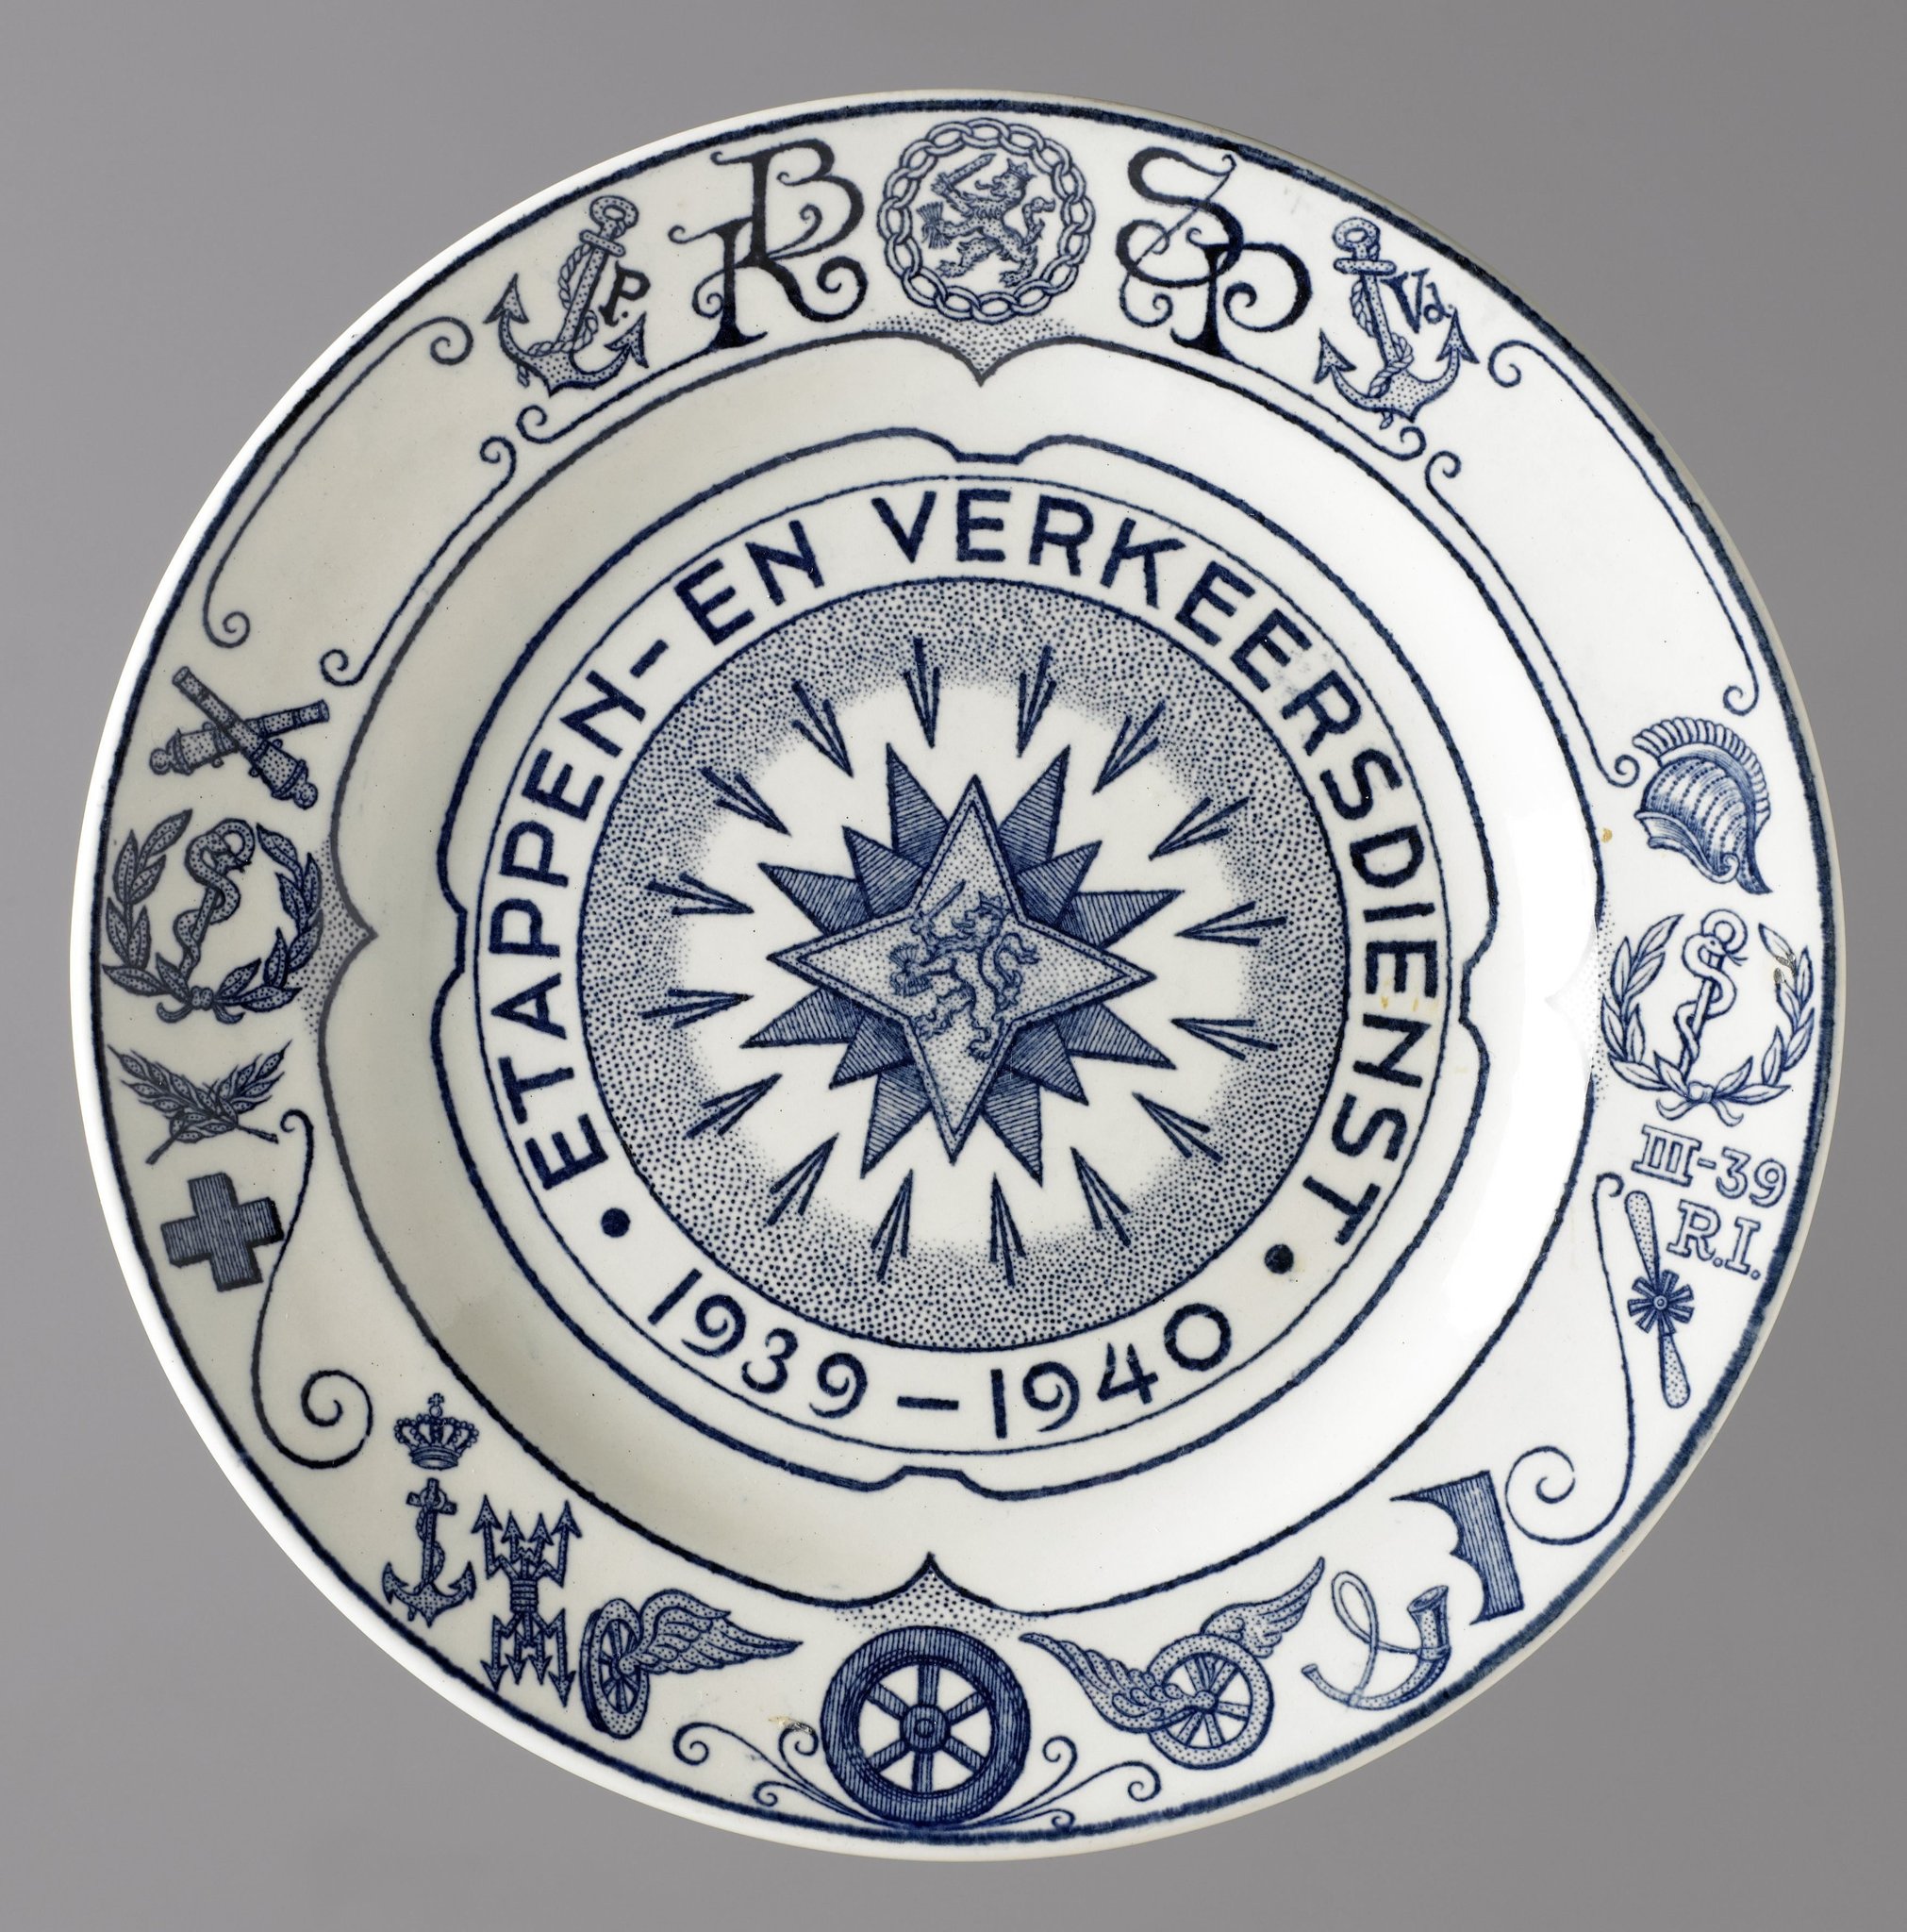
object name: commemorative plate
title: Etappen- en verkeersdienst 1939-1940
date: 1940-1982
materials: earthenware, glaze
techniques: firing, vitrification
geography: maastricht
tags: netherlands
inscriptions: mark, inscription: ‘ETAPPEN- EN VERKEERSDIENST. 1939-1940’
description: Herdenkingsbord met schuine oplopende rand waarop allerlei symbolen in donkerblauw. In het midden van het vlak: nederlandse leeuw op vier-puntige ster. Gedeelte van het merk is achter sticker met: Bord No. 568 en de verklaring van de onderscheidingstekens op het bord.